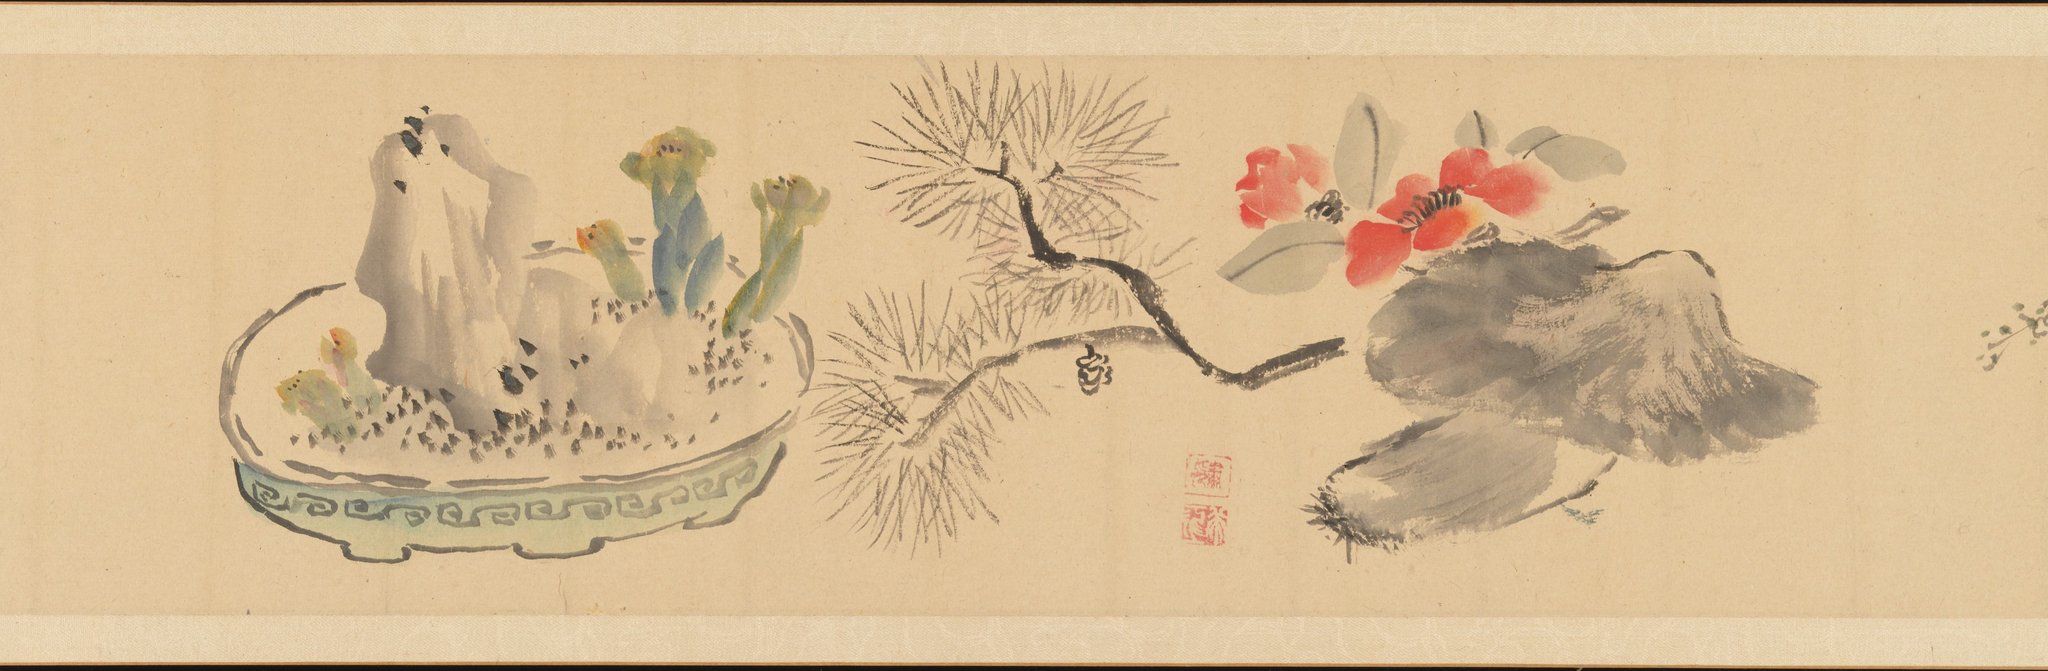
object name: handscroll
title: Letter Enclosing Flowers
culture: japanese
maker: okada hankō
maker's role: artist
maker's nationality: japanese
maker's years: 1782-1846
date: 1831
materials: ink, paper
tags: flowers,plants